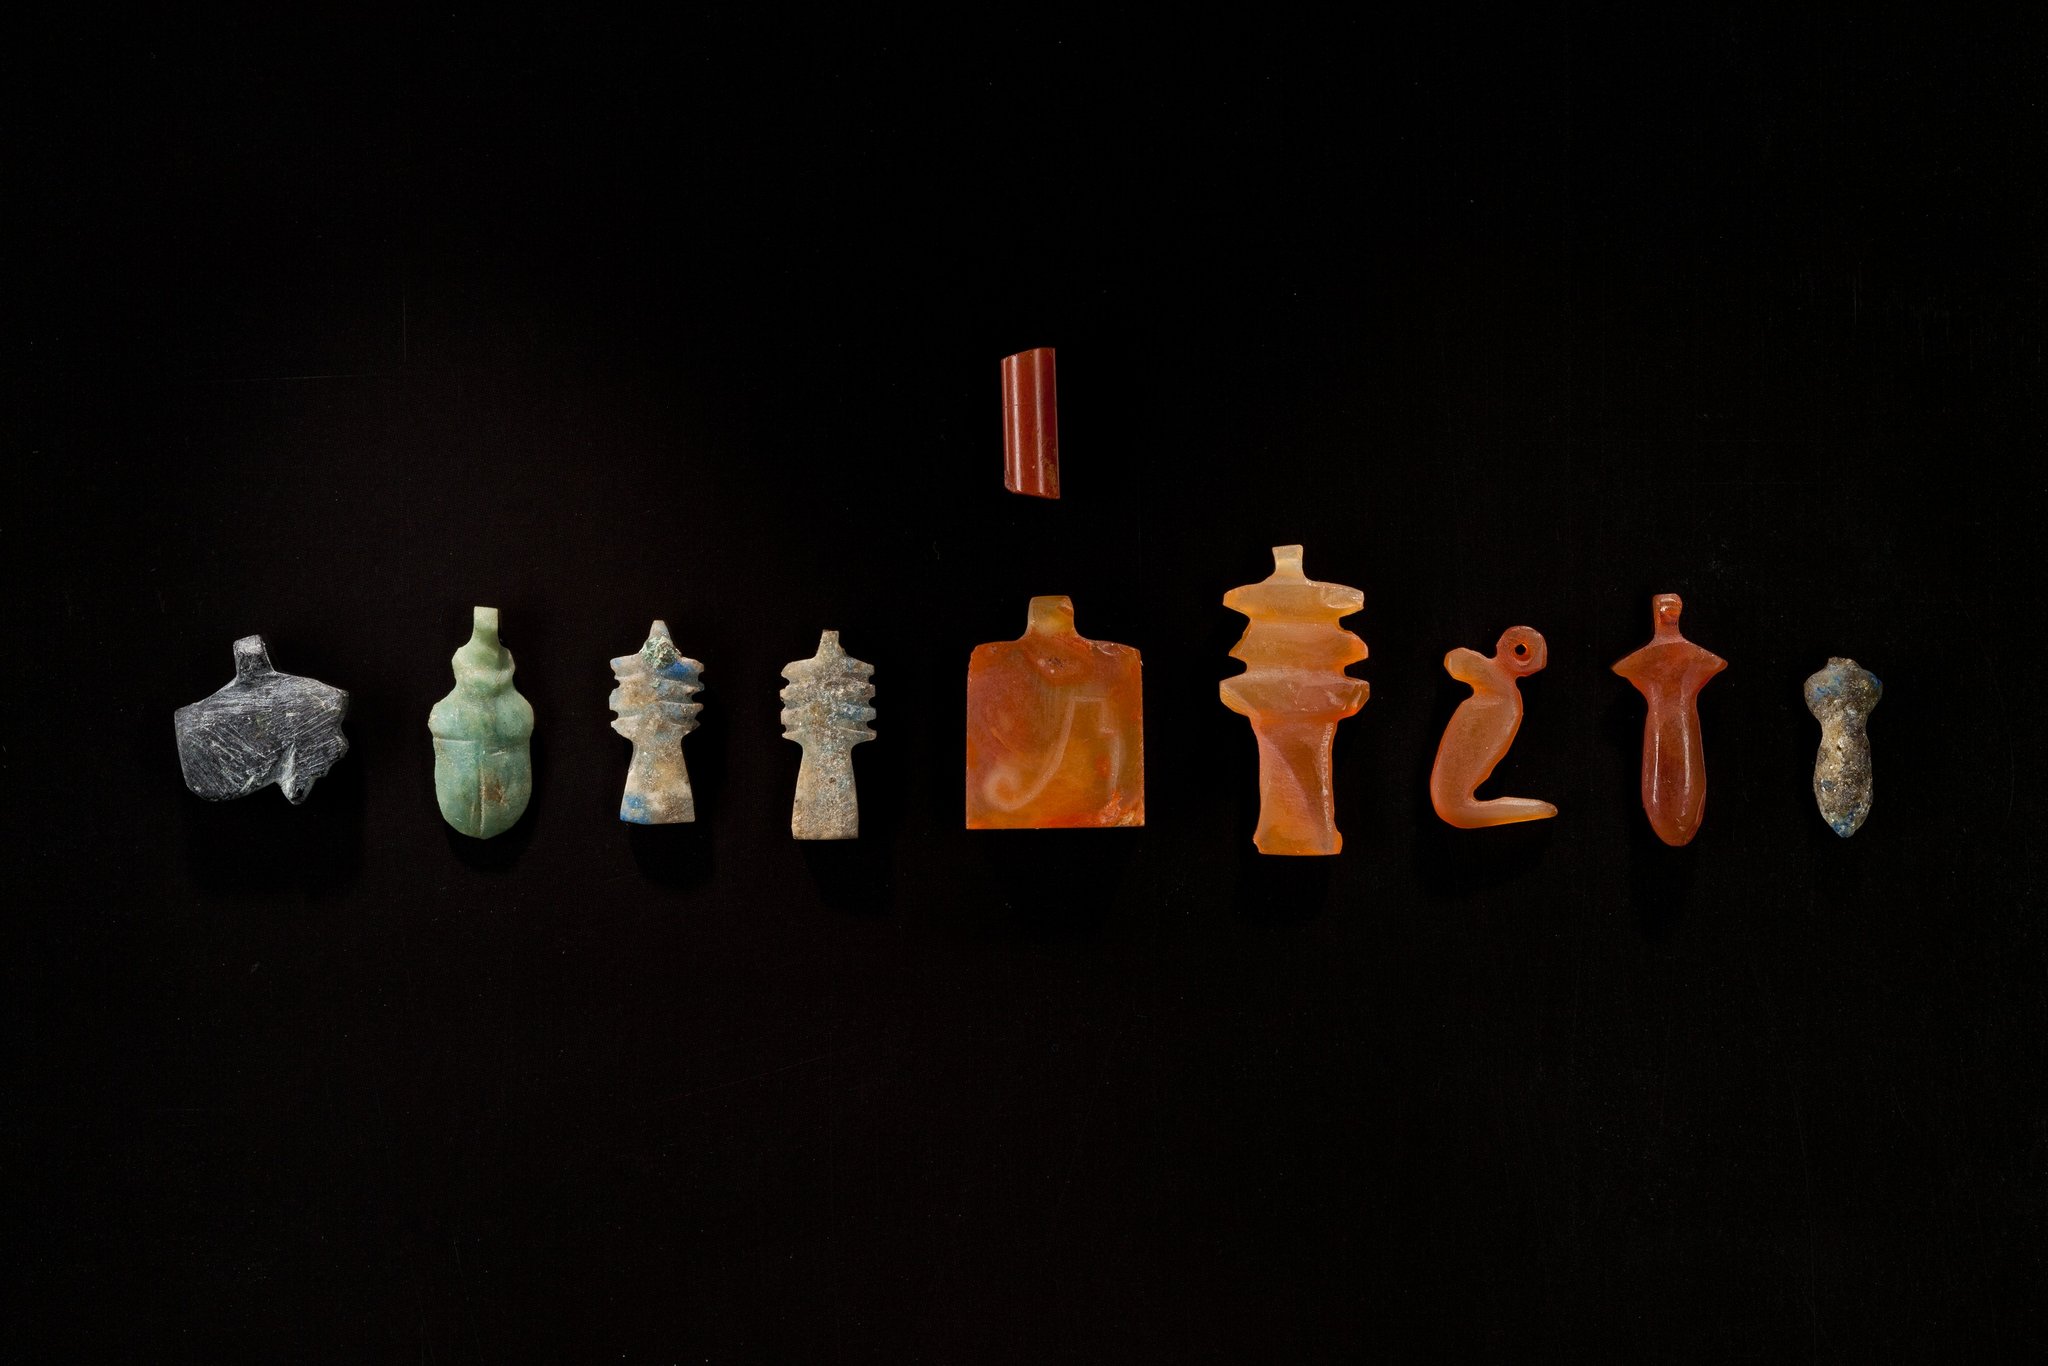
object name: amulet, 1 wedjat, 1 scarab, 3 djed pillar, 1 incised plaque setep, 2 wadj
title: 10 Amulets: 1 wedjat, 1 scarab, 3 djed pillars, 1 incised plaque, 1 uraeus, 2 wadj signs, and 1 cylindrical bead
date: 990-970 BCE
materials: gemstone, glass, lapis lazuli, stone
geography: egypt